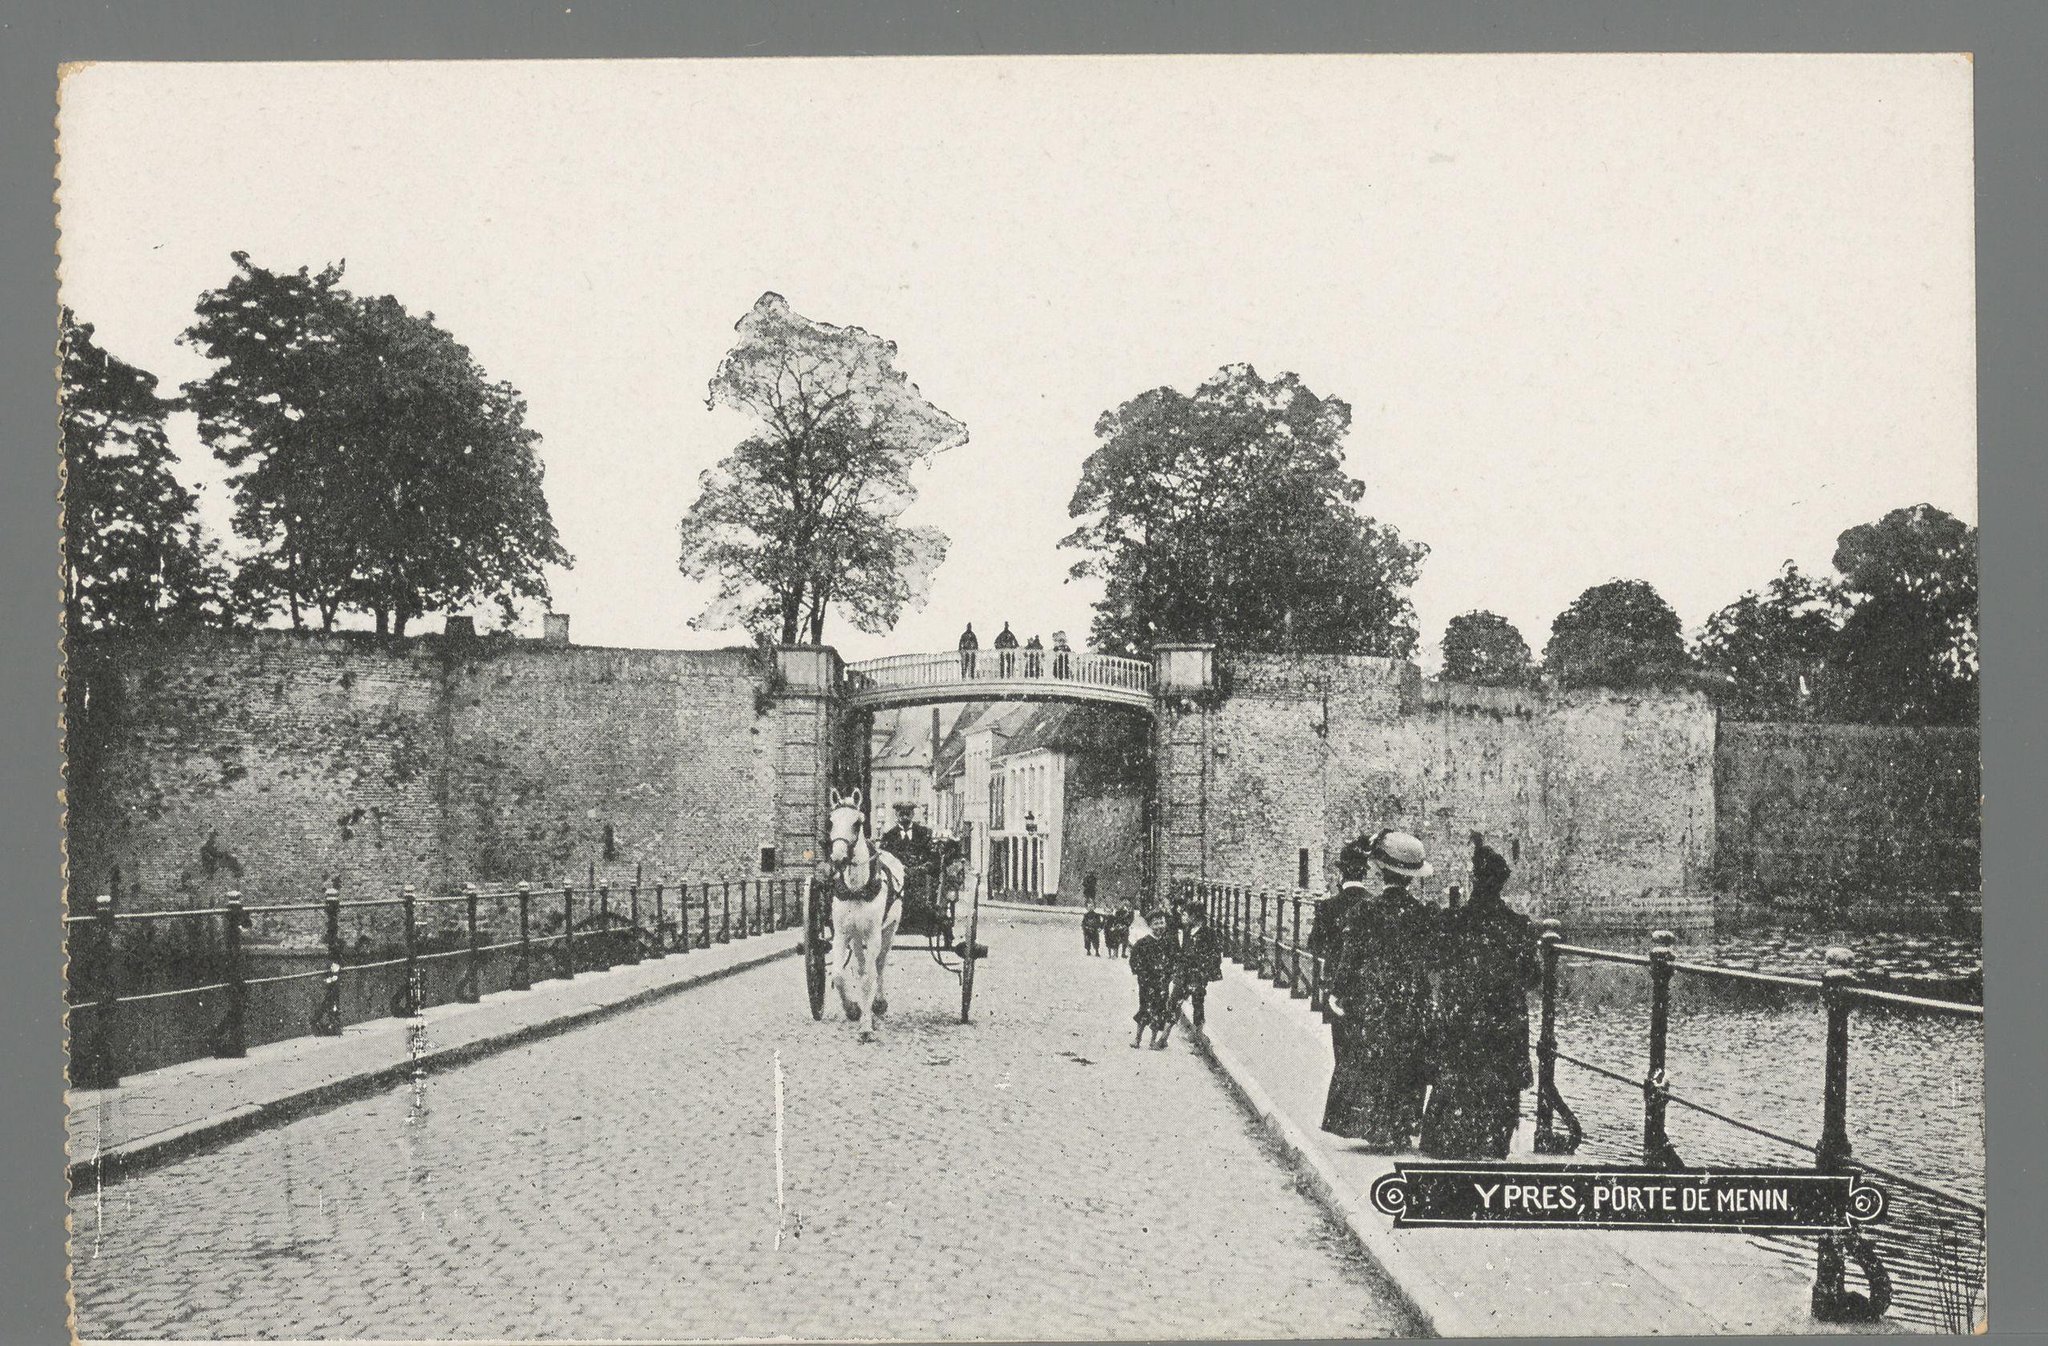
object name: ansichtkaart, prentbriefkaart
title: Ypres, Porte de Menin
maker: Anonymous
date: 1906-1918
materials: cardboard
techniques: autotype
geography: ieper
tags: gate, entrance, city-view in general; 'veduta' (+ city(-scape) with figures, staffage)